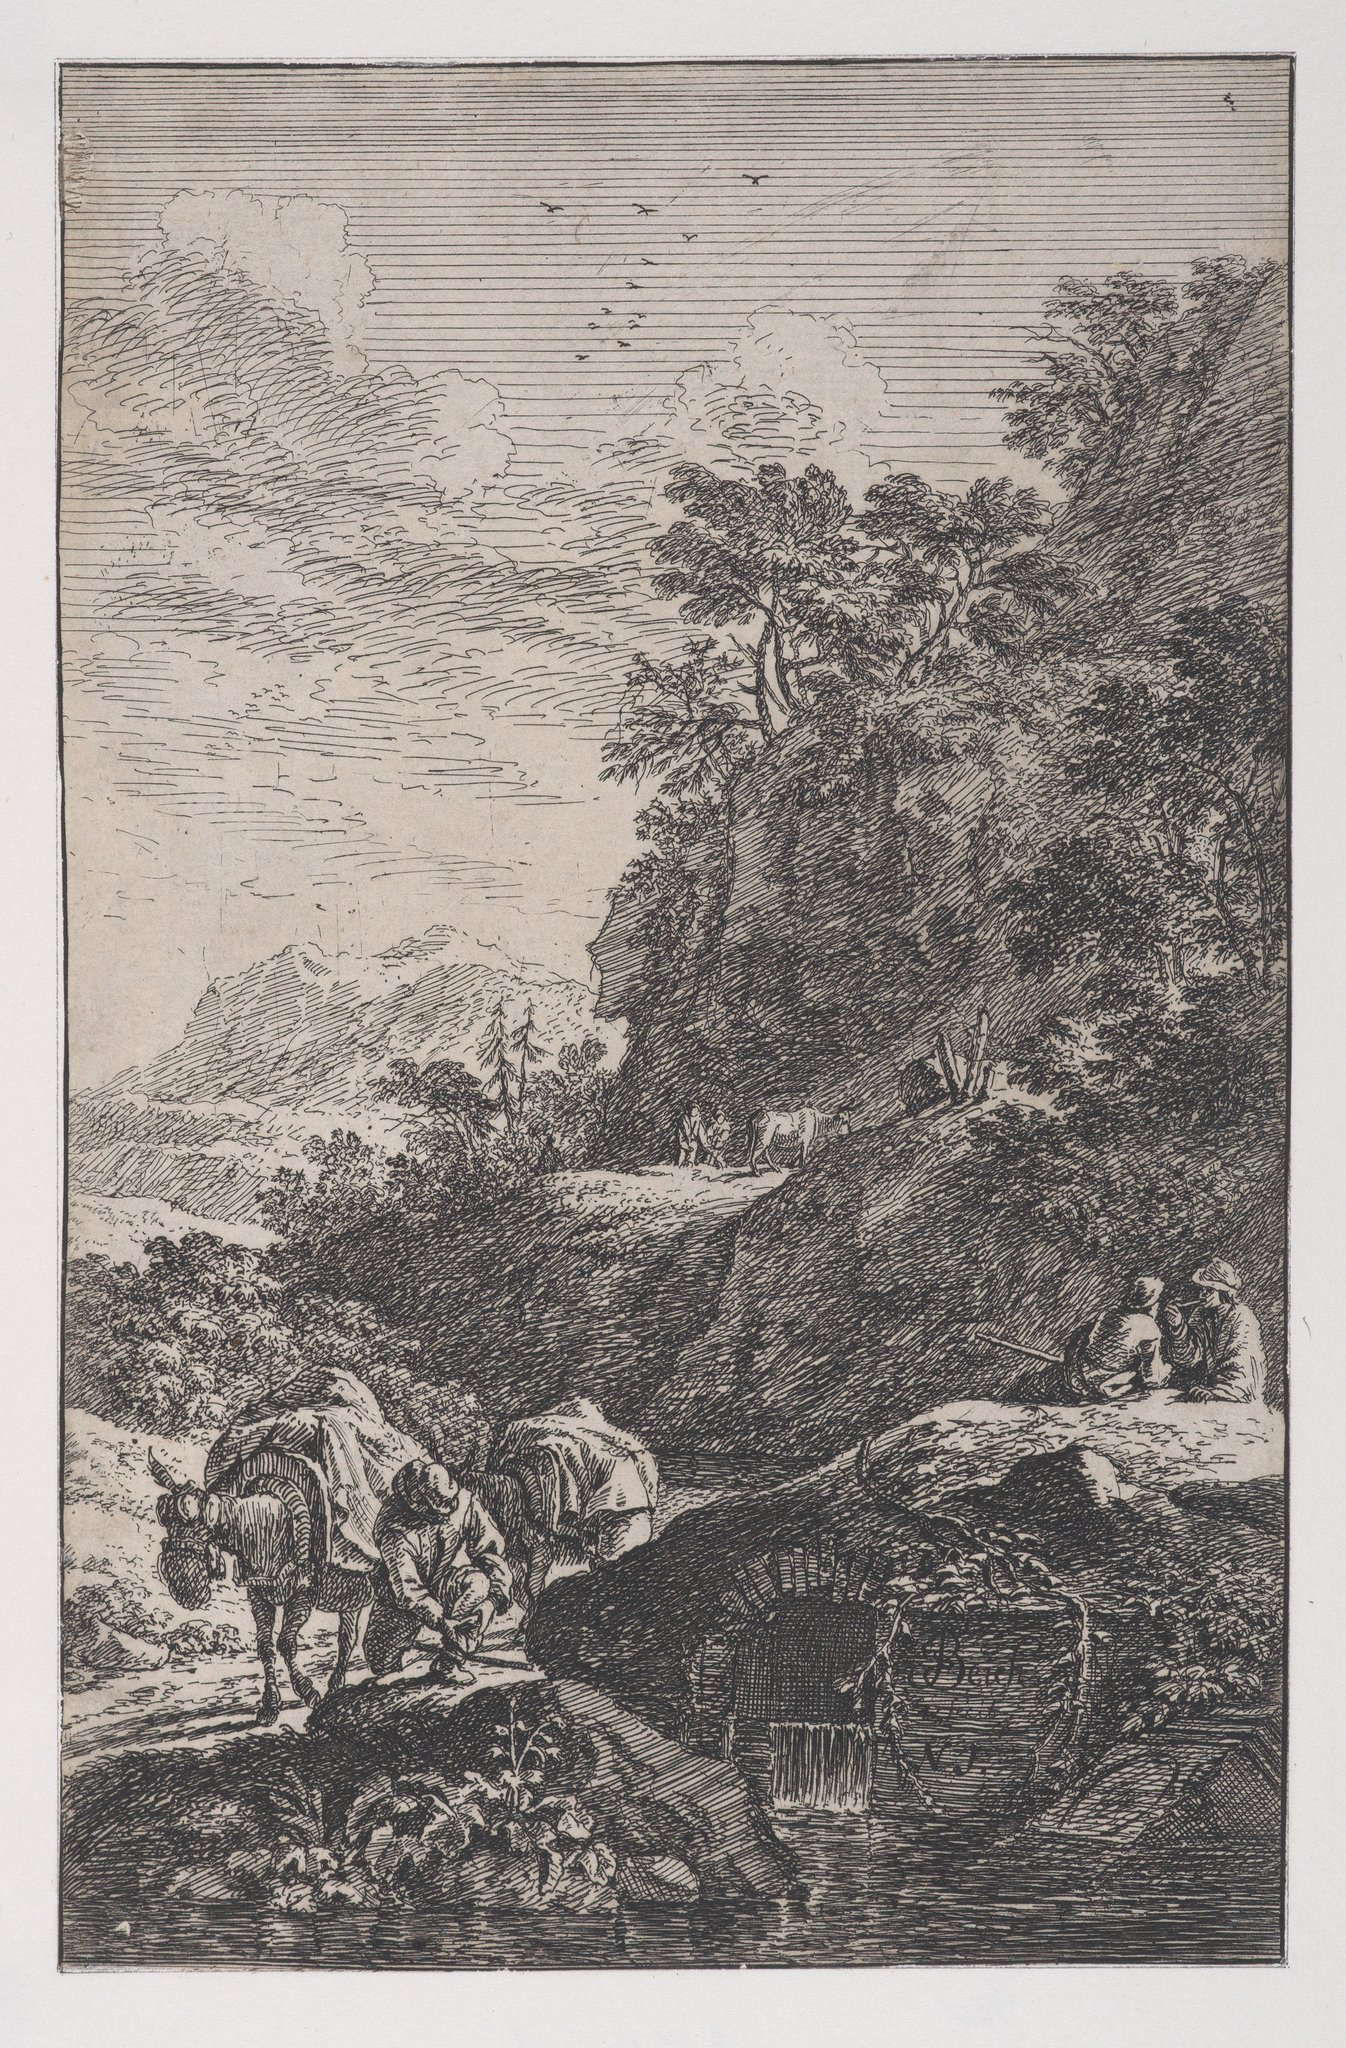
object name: print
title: Plate 1: a peasant checking the hoof of his mule by a stream, from 'Landscapes in the manner of Salvator Rosa' (Die Landschaften in Sal. Rosa's)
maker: franz joachim beich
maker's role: artist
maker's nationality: german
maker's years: 1665-1745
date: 1700-1725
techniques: etching